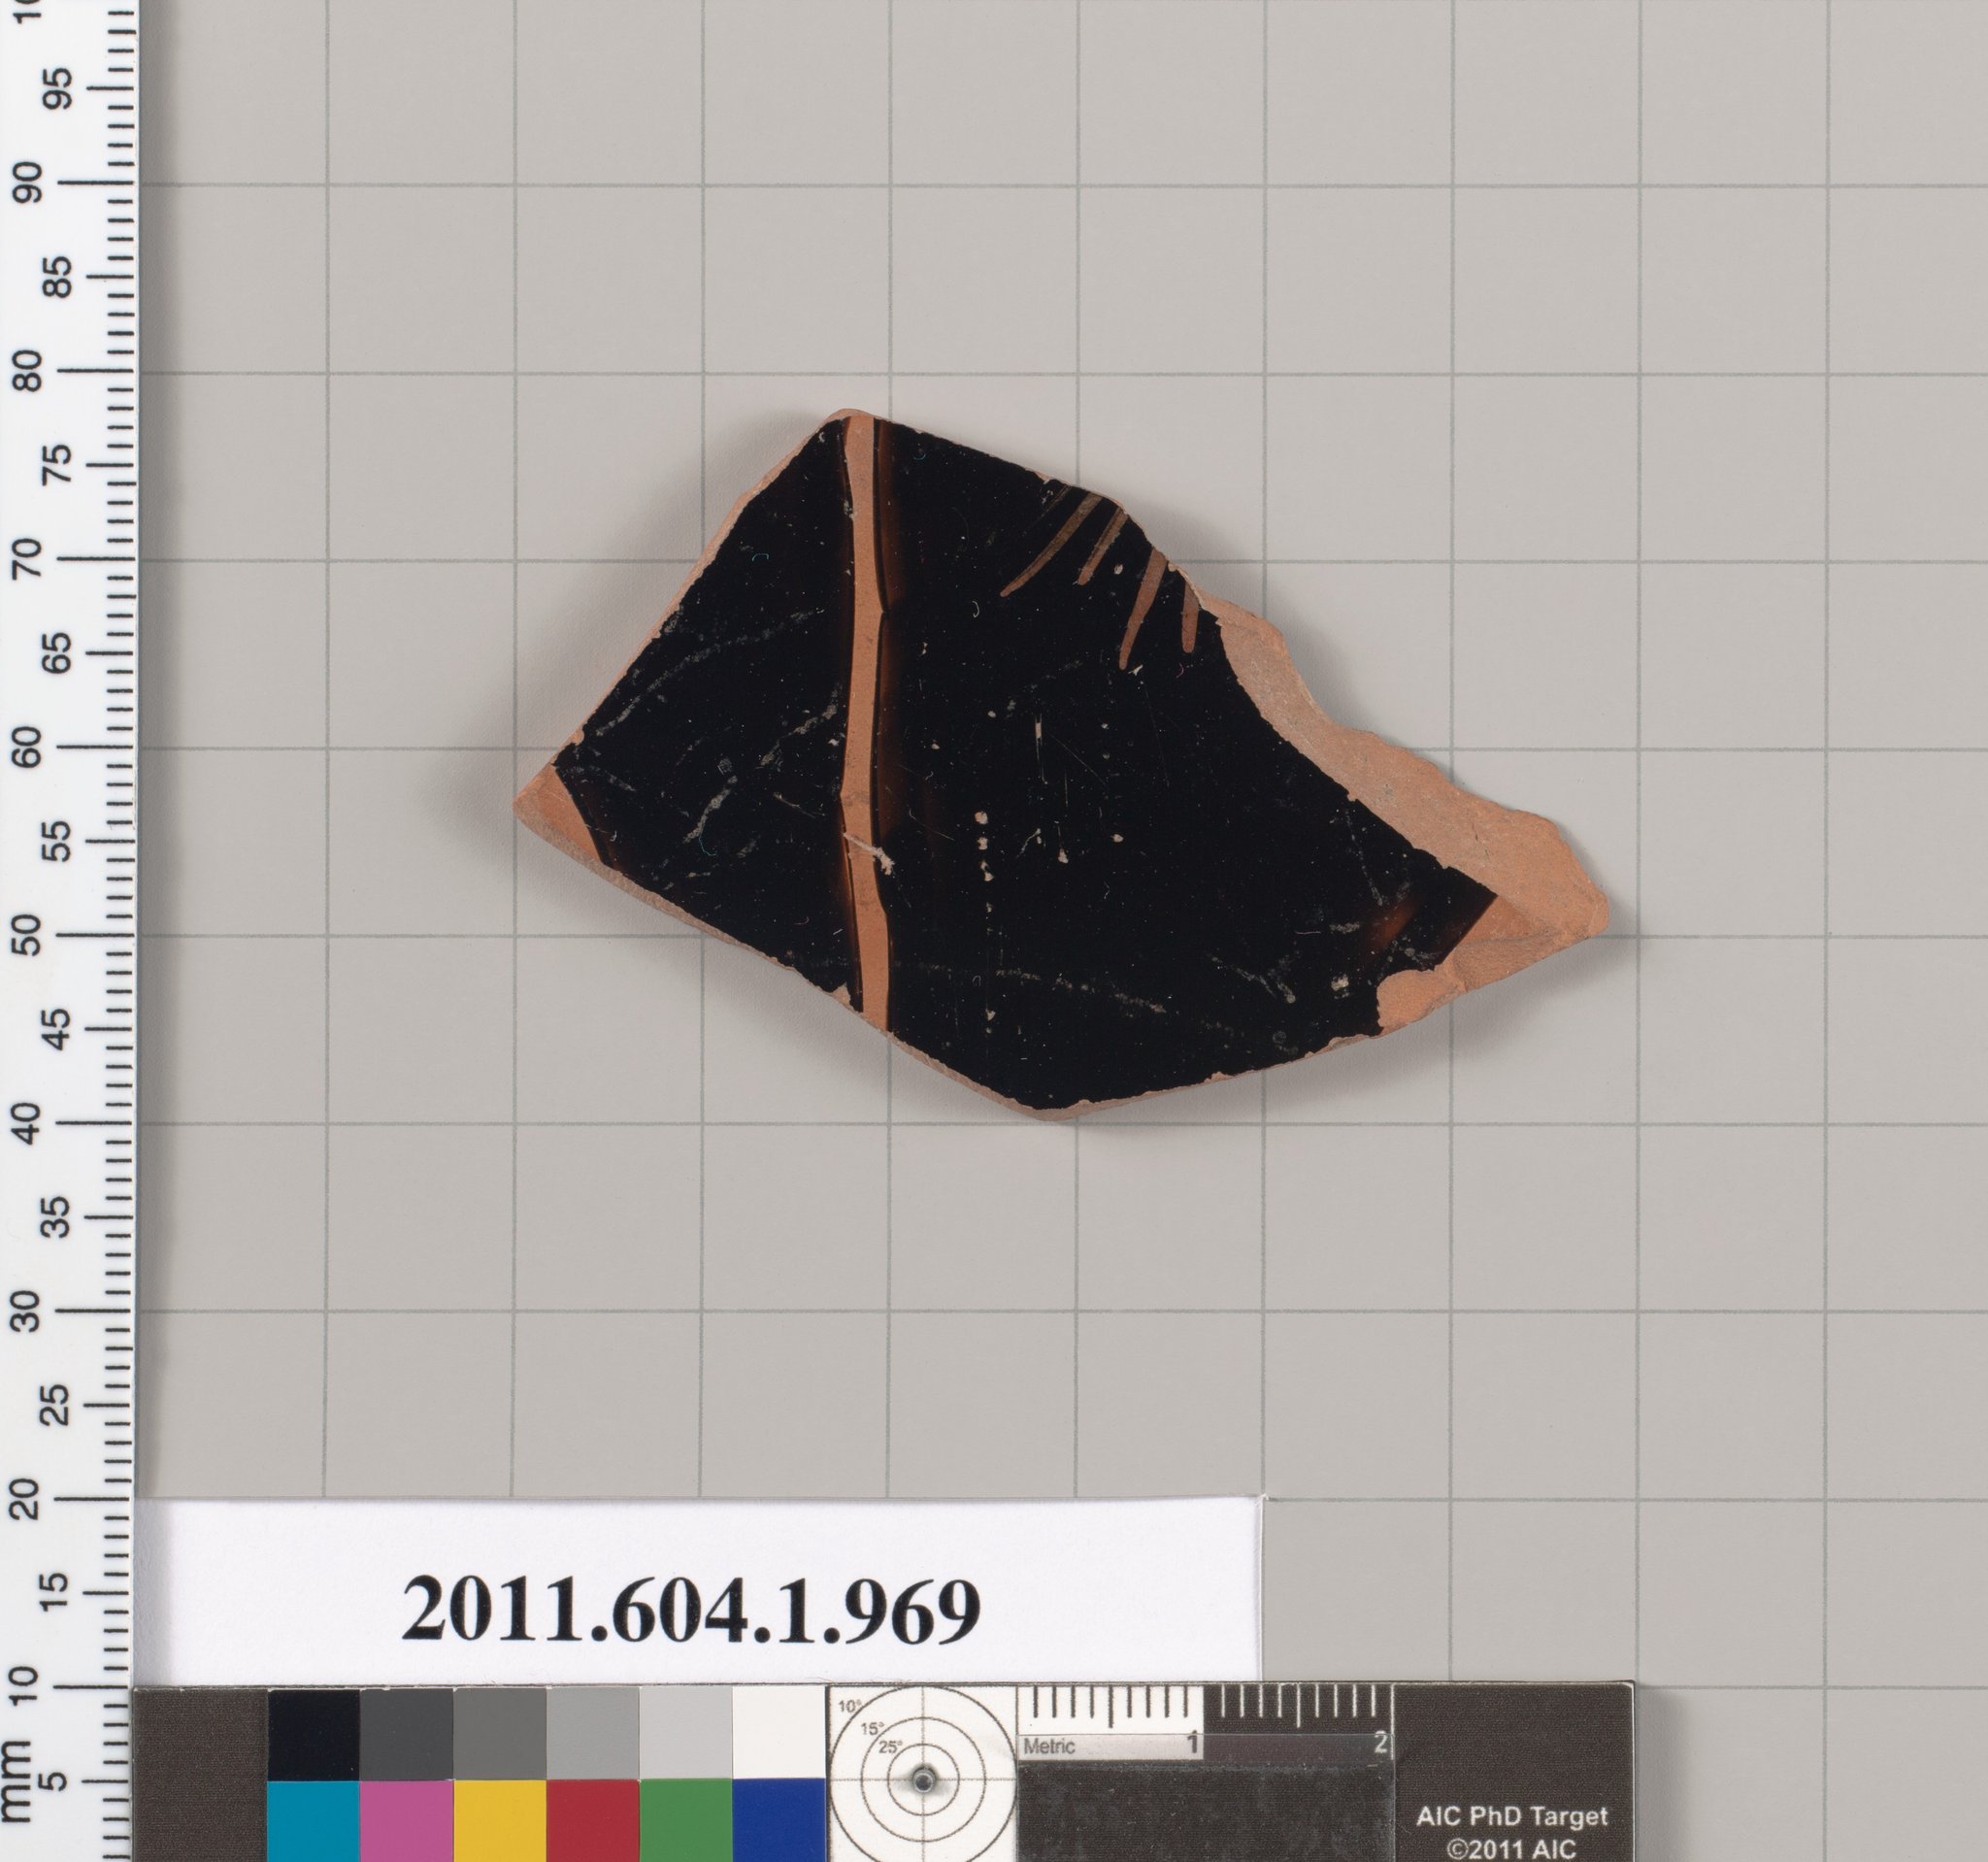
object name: kylix fragment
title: Terracotta fragment of a kylix (drinking cup)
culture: greek, attic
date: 490-480 BCE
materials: terracotta